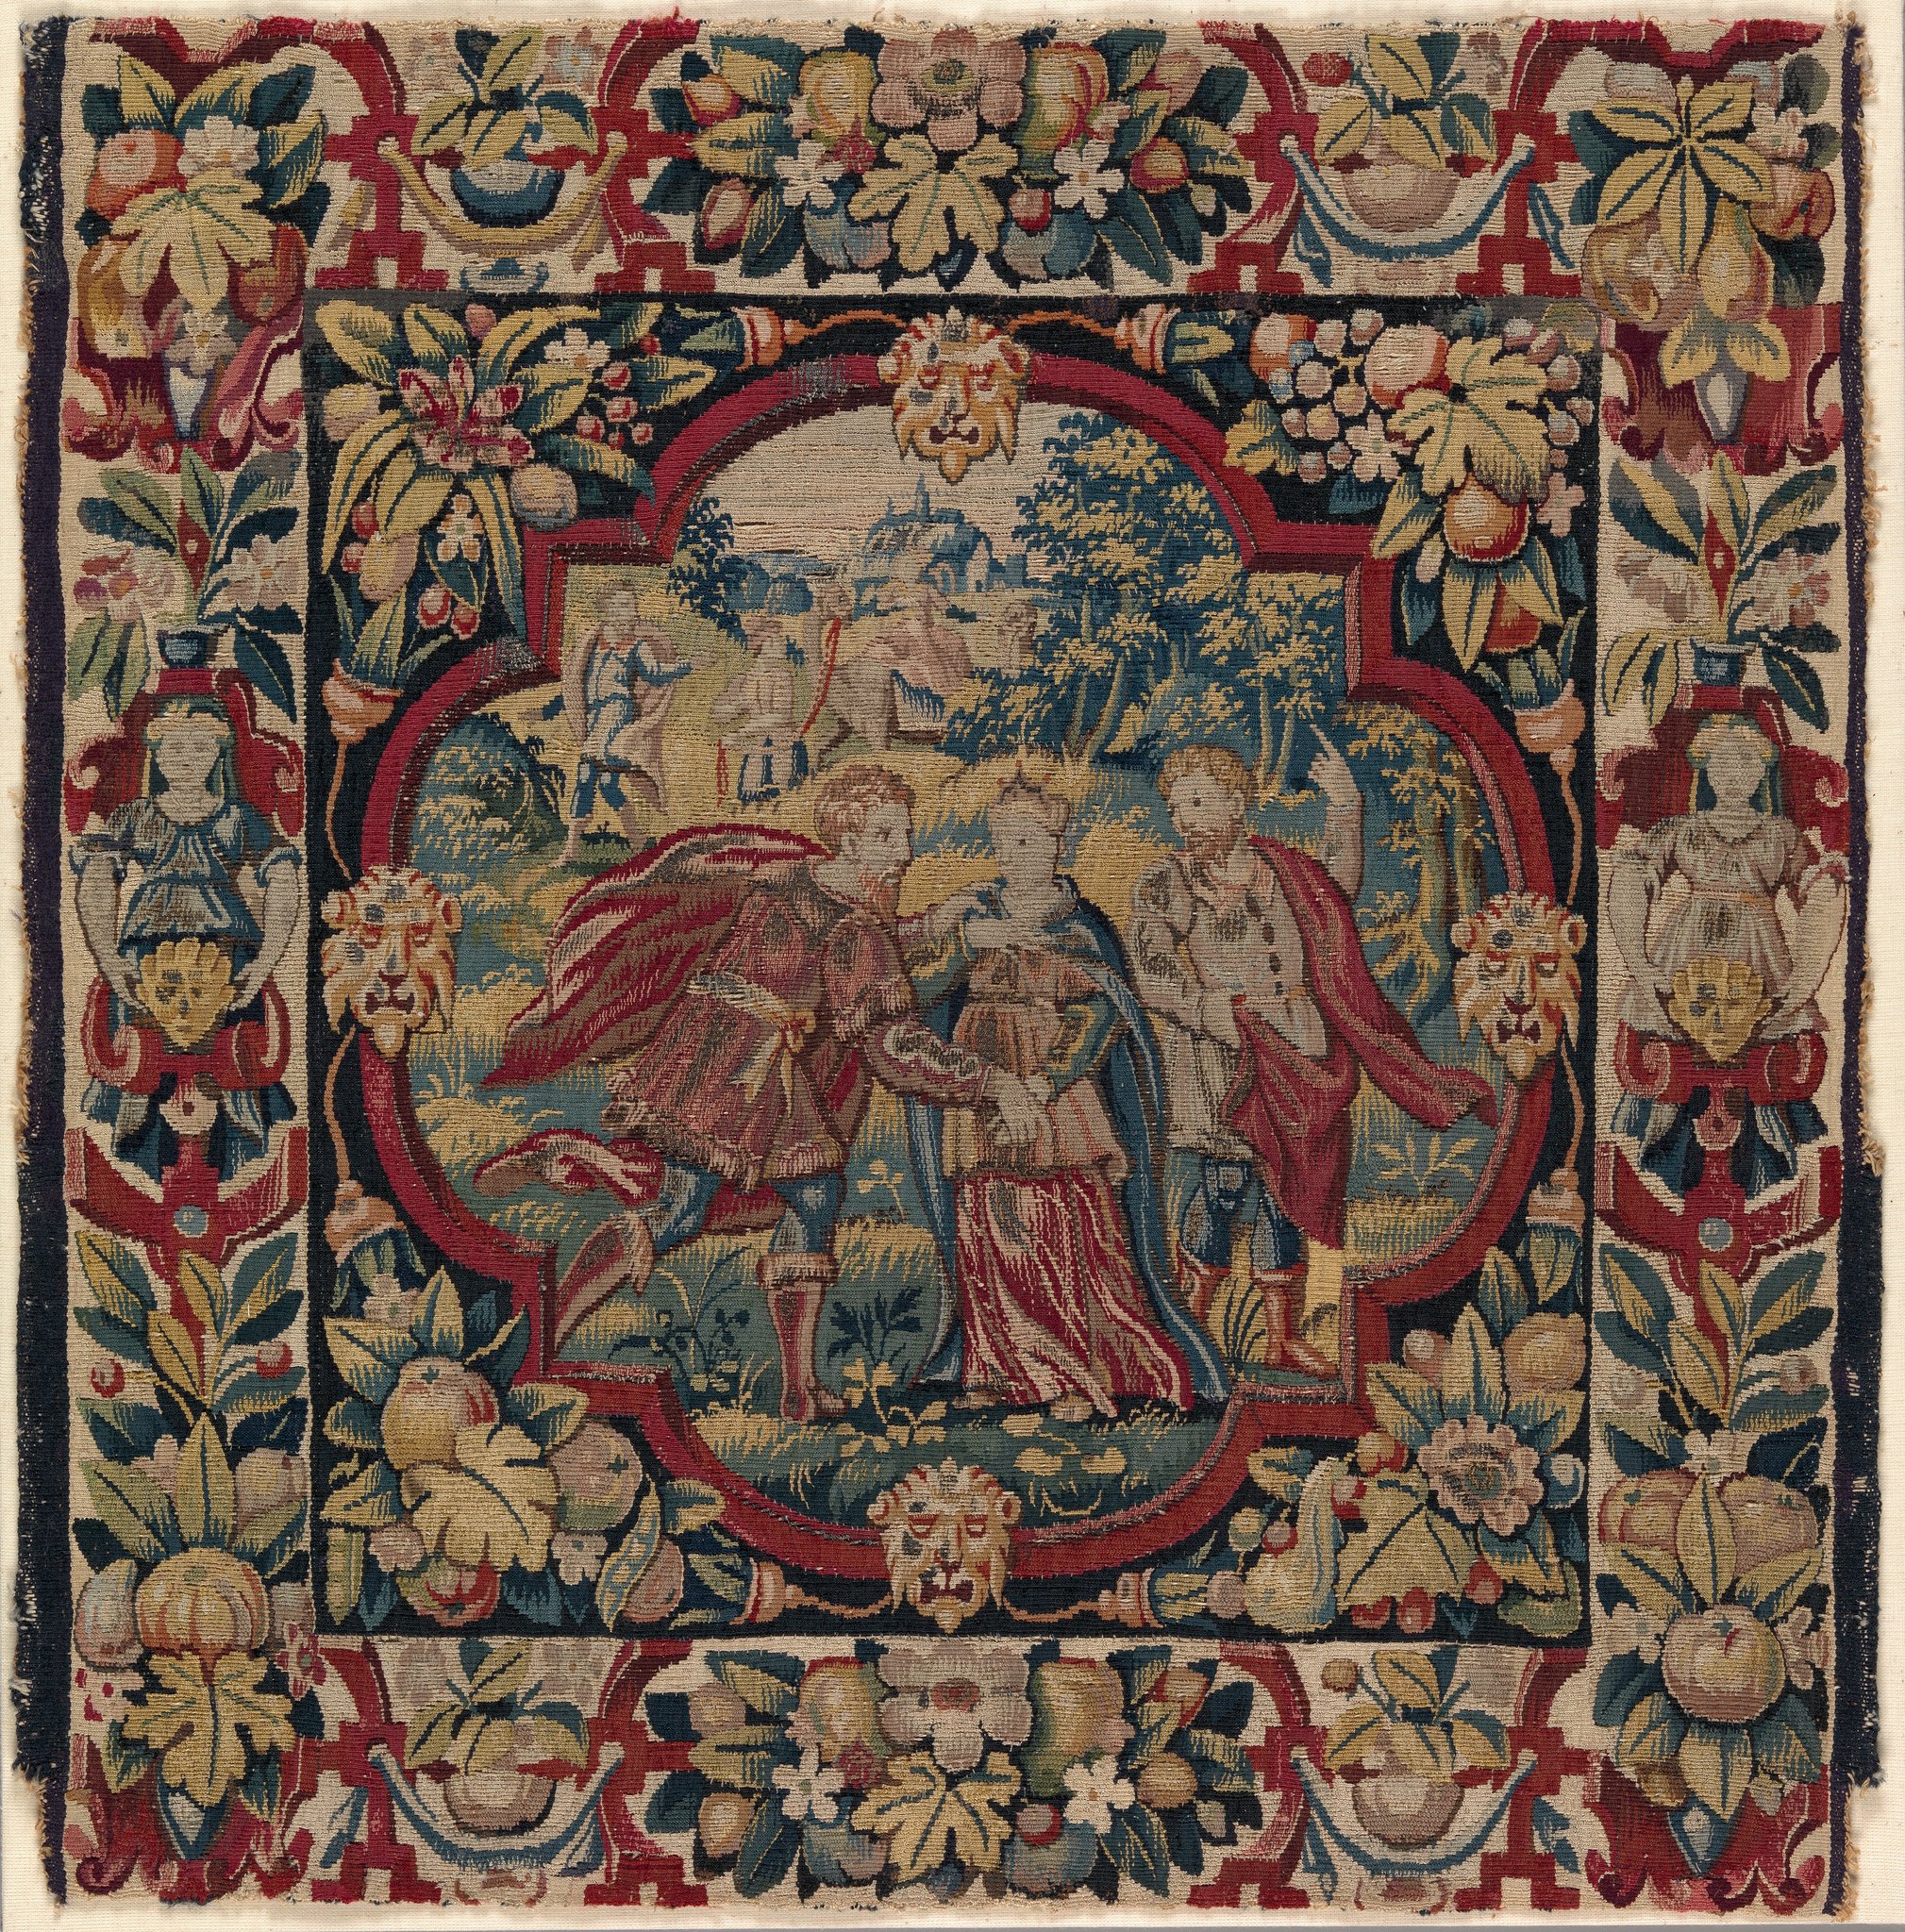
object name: cushion cover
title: The Meeting of Isaac and Rebekah from the Story of Abraham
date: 1600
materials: silk, silver gilt, thread, wool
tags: men,women,flowers,isaac,rebecca